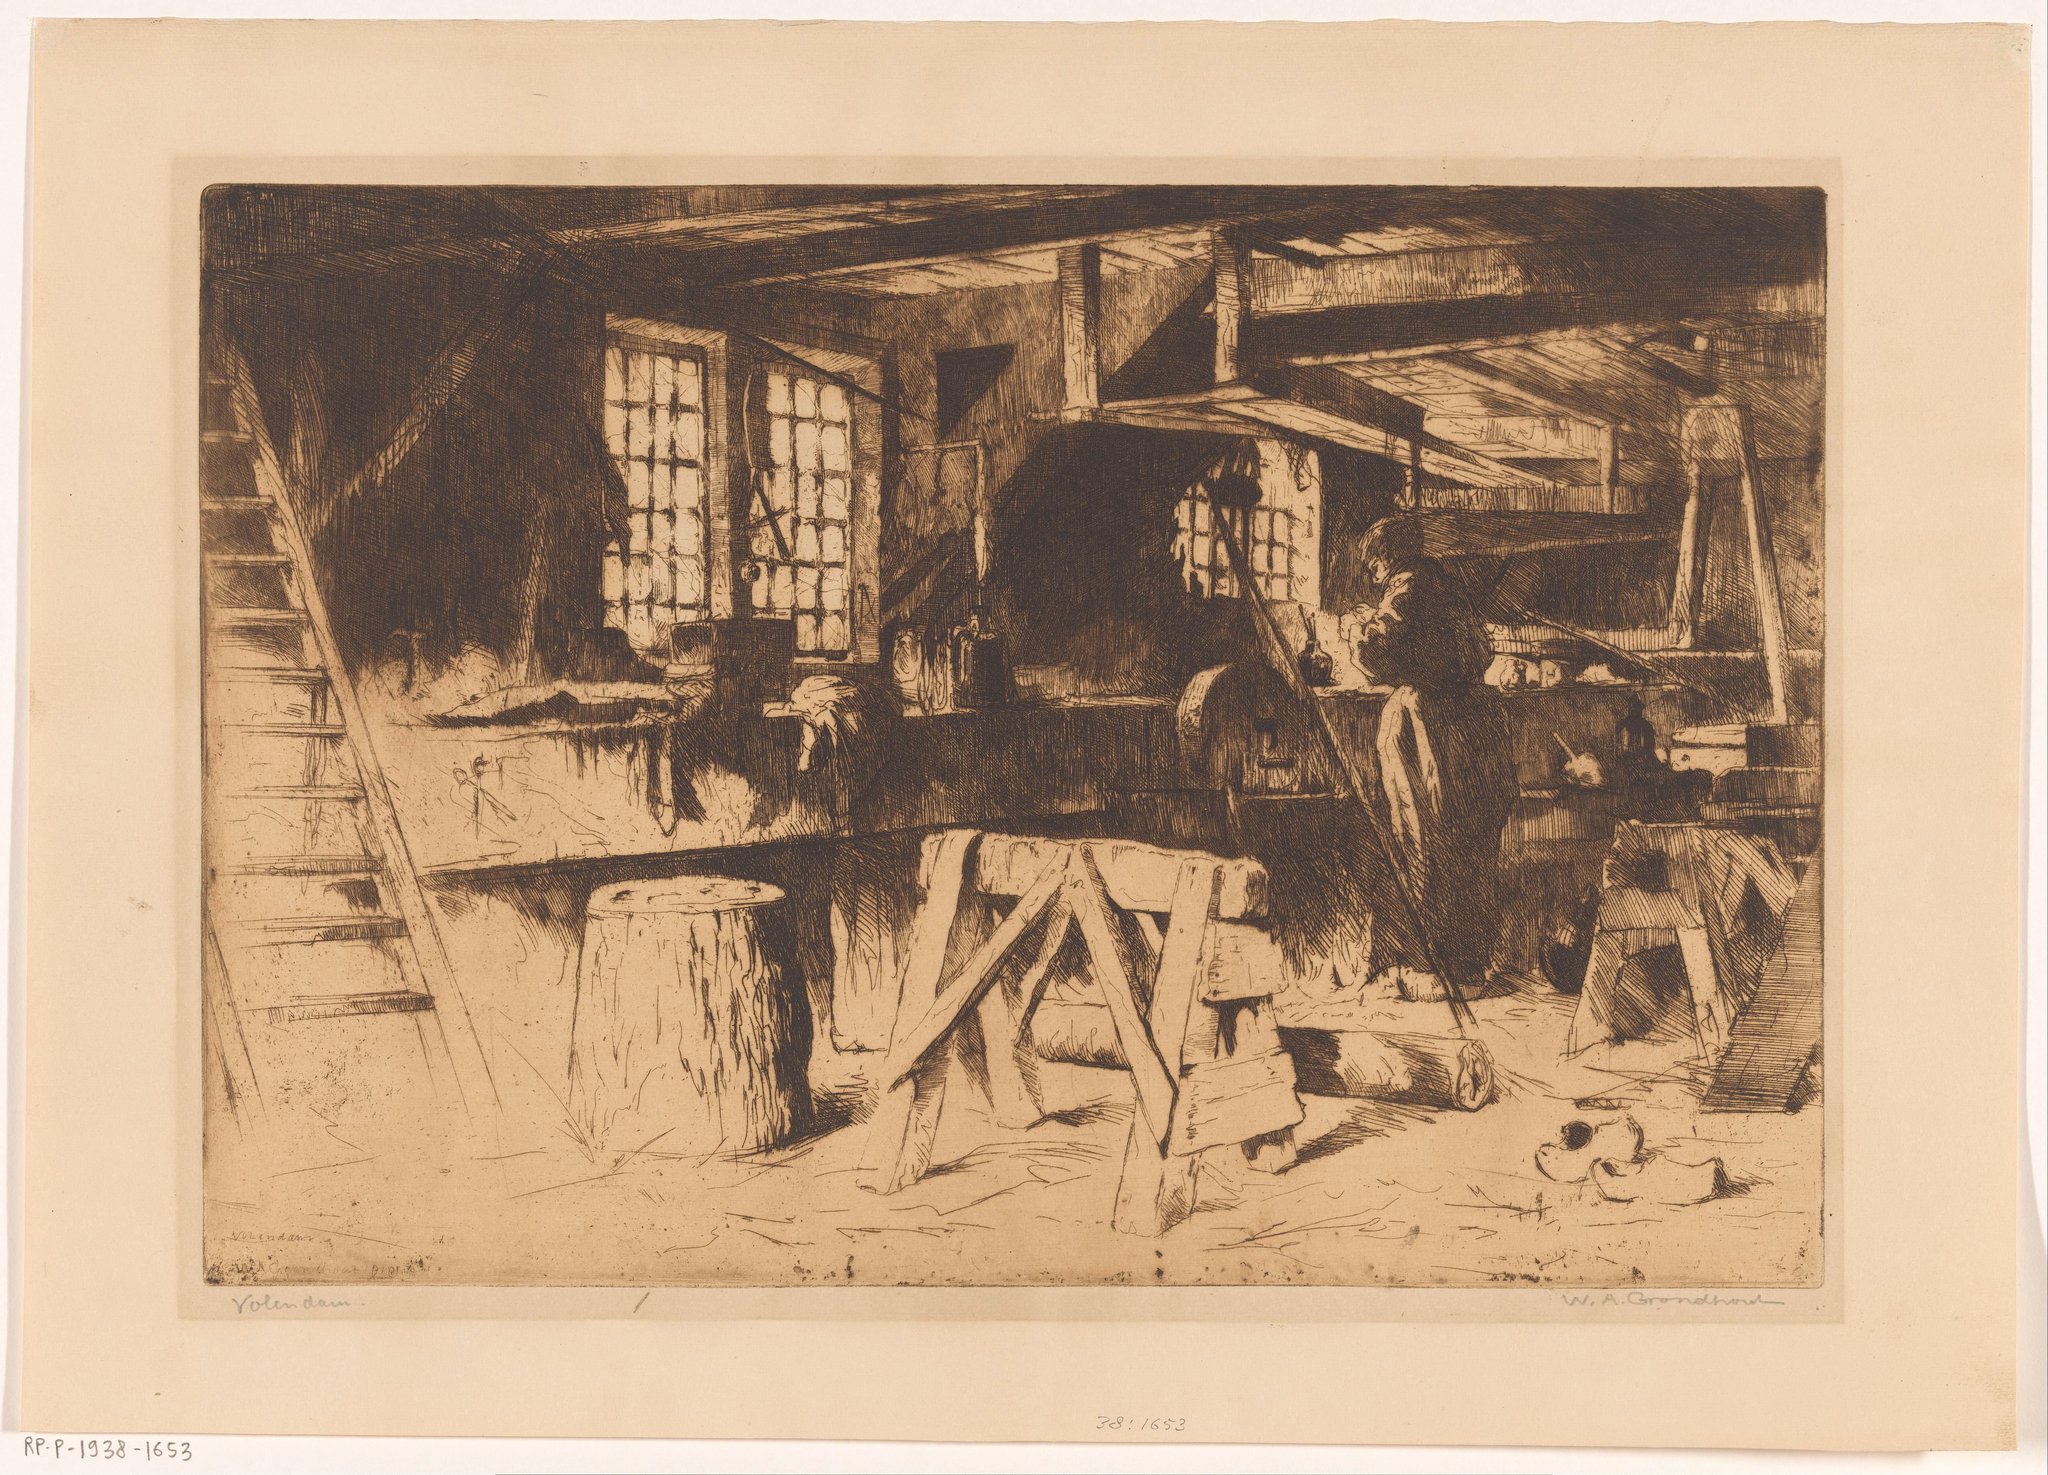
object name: print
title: Volendam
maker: willem adrianus grondhout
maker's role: draughtsman, painter, print maker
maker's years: 1878-1934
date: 1888-1934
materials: paper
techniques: etching, intaglio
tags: carpenter, workshop-interior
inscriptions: collector's mark: Lugt 2228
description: Het interieur van een timmermanswerkplaats in Volendam.